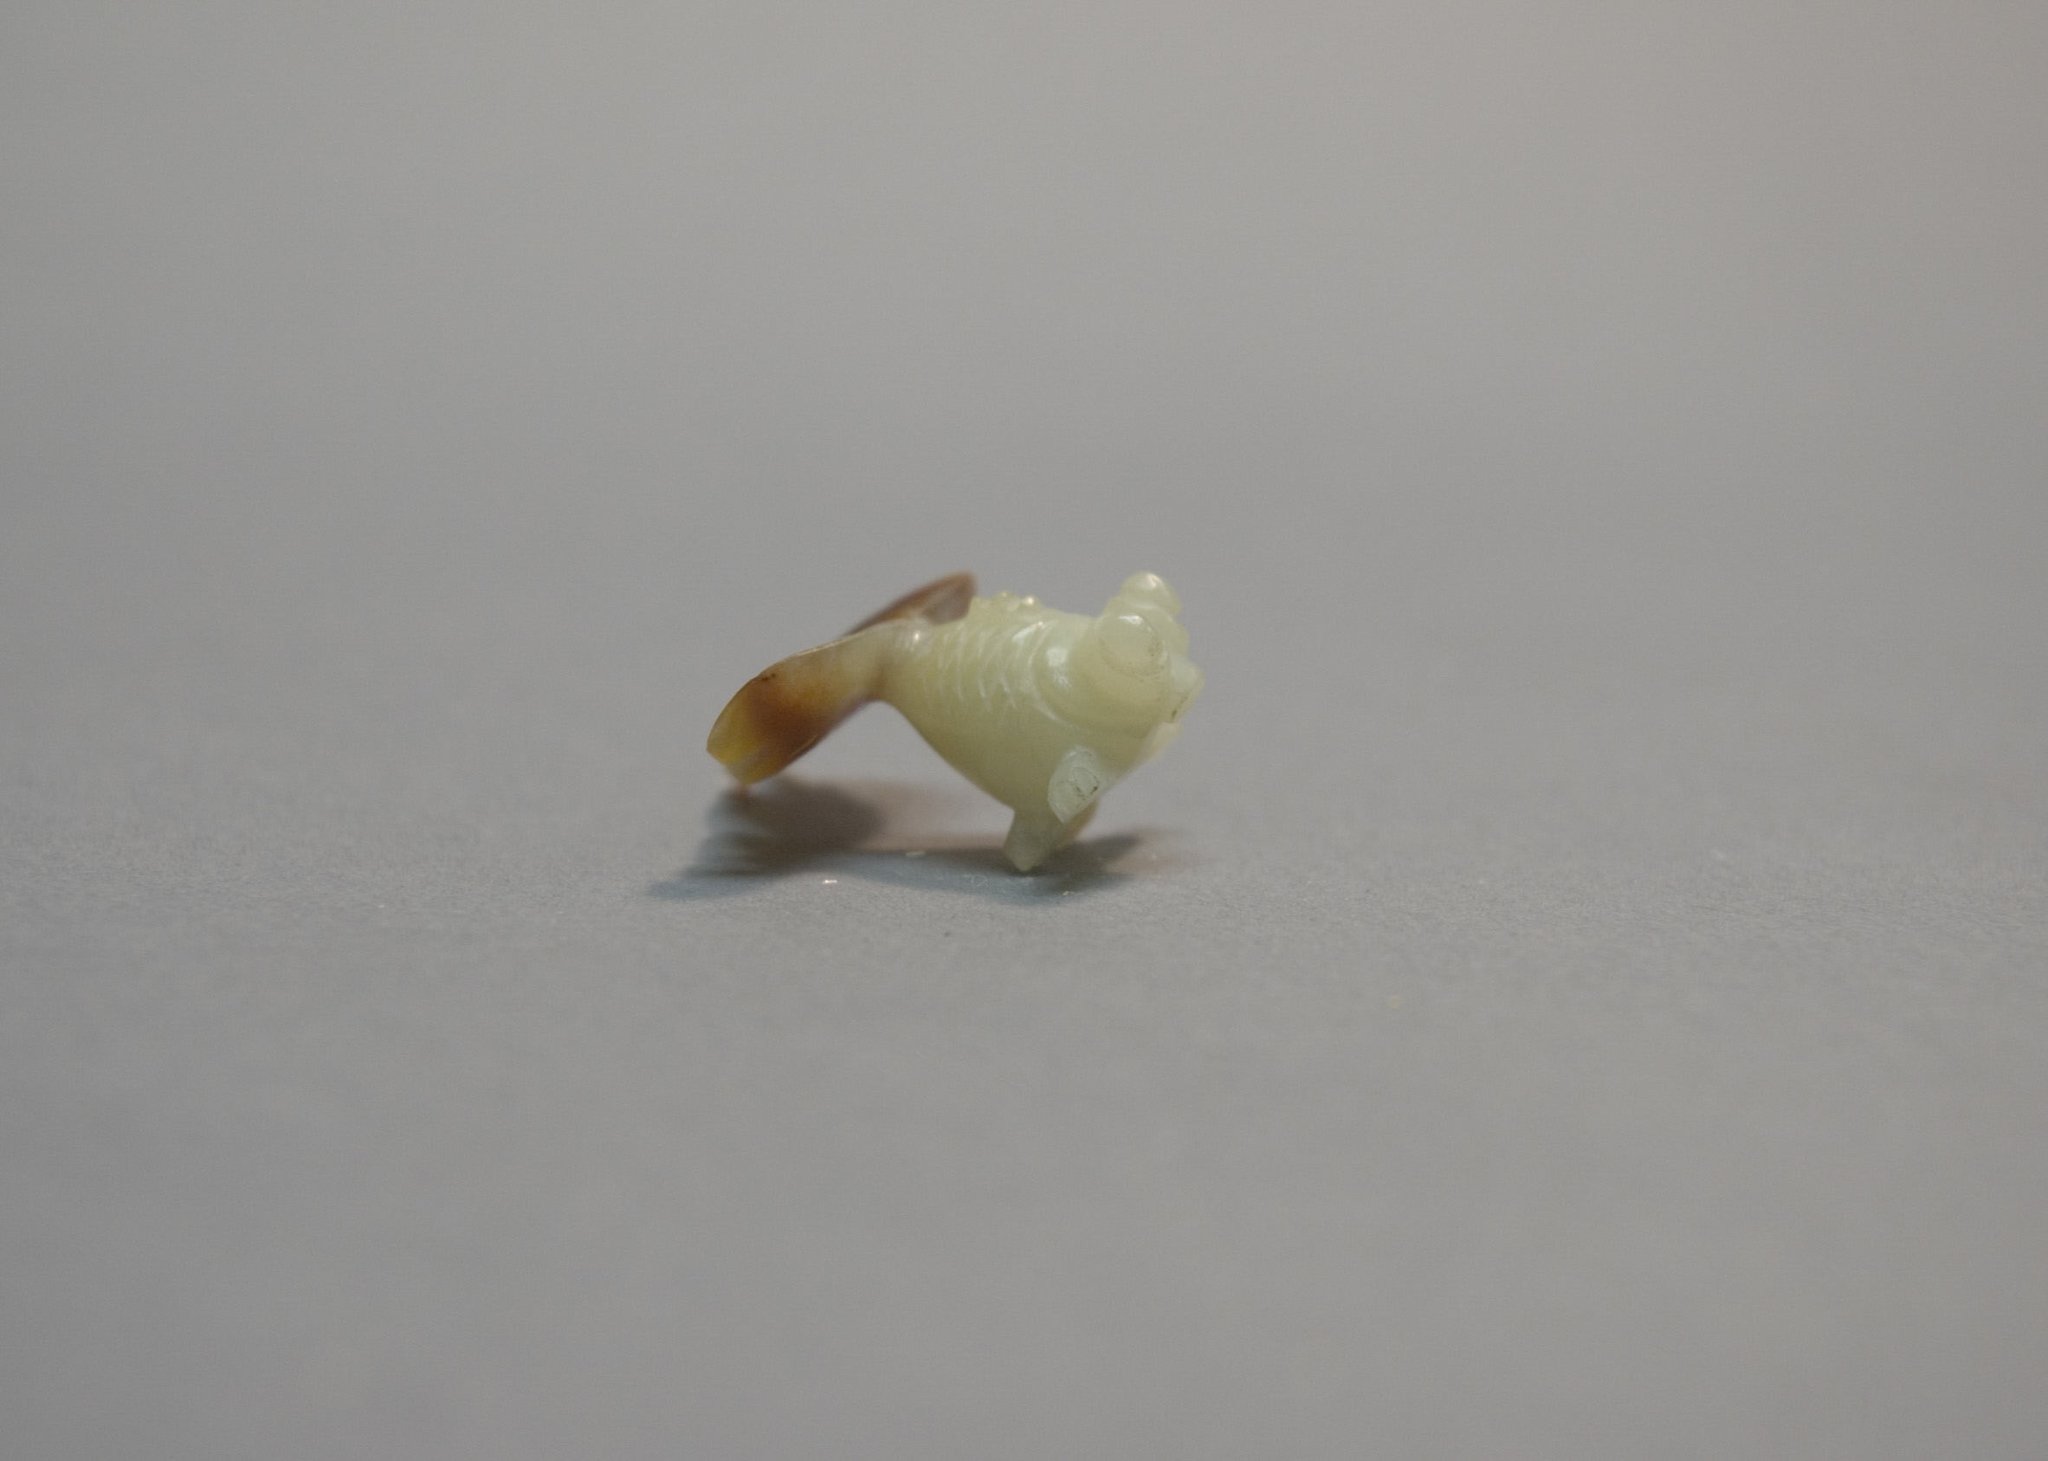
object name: jade carving material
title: Piece of "False Jade" Carved in Shape of a Flying Fish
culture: chinese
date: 1901-2000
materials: jade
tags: fish